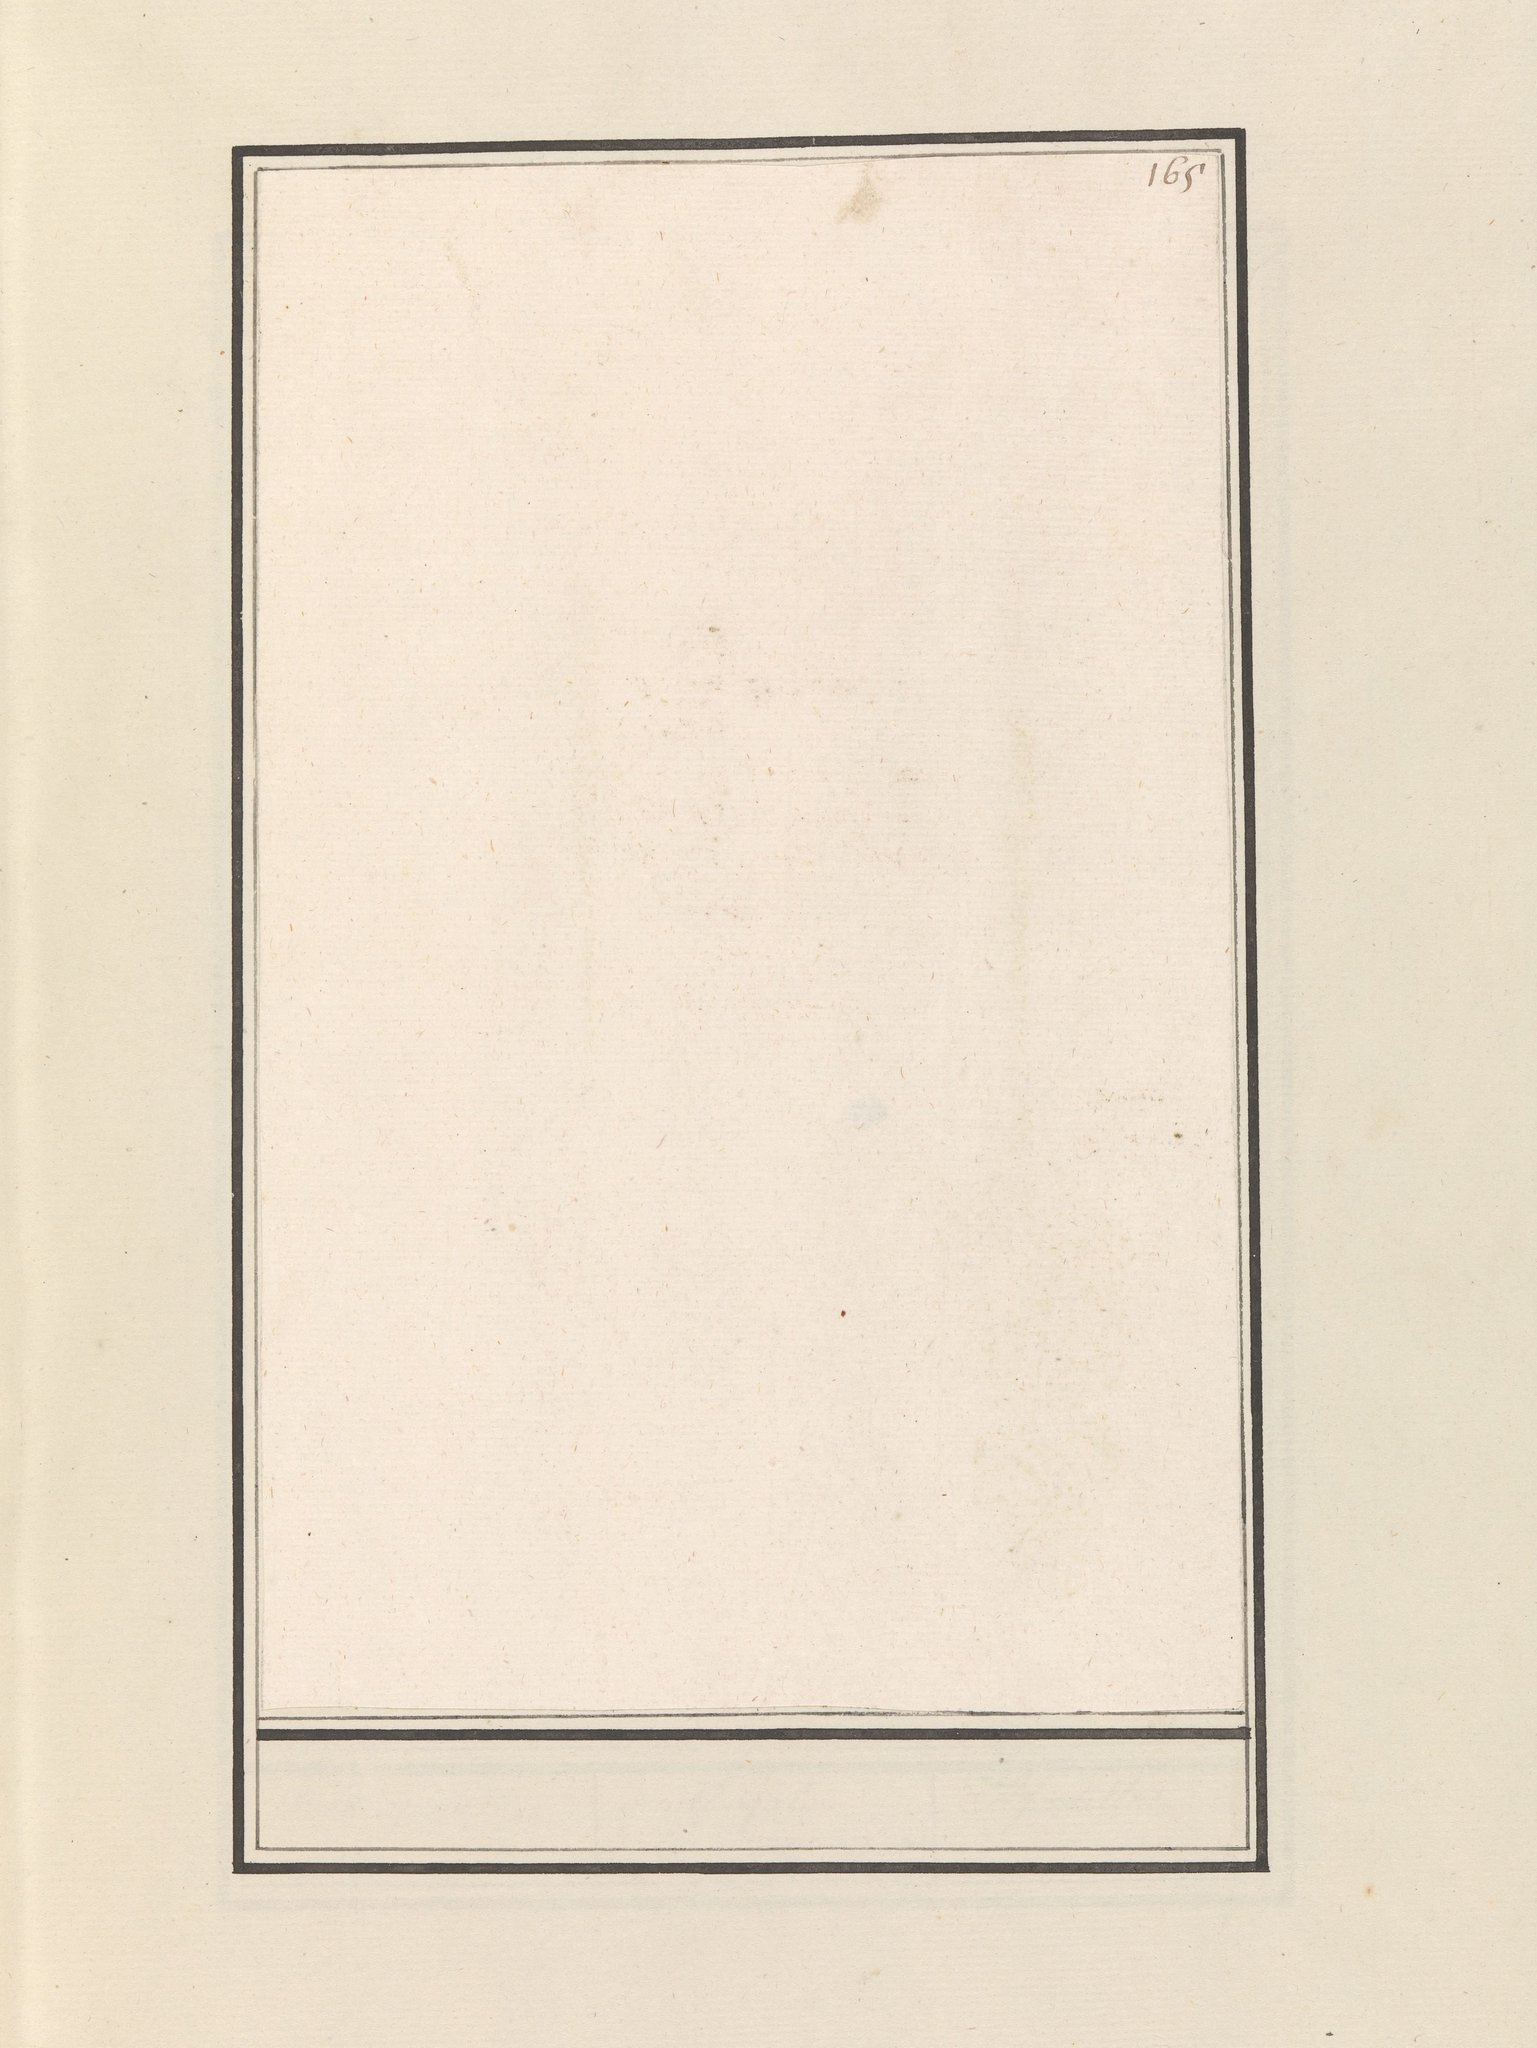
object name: drawing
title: Leeg blad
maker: Anonymous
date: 1809-1814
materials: paper, watercolor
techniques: brush, pen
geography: southern netherlands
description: Leeg blad, opgeplakt binnen omlijsting. Rechtsboven genummerd: 165. Onderdeel van het tweede album met tekeningen van bloemen en planten. Negende van twaalf albums met tekeningen van dieren, vogels en planten bekend rond 1600, gemaakt in opdracht van keizer Rudolf II. Met toelichting in Nederlands, Latijn en Frans.